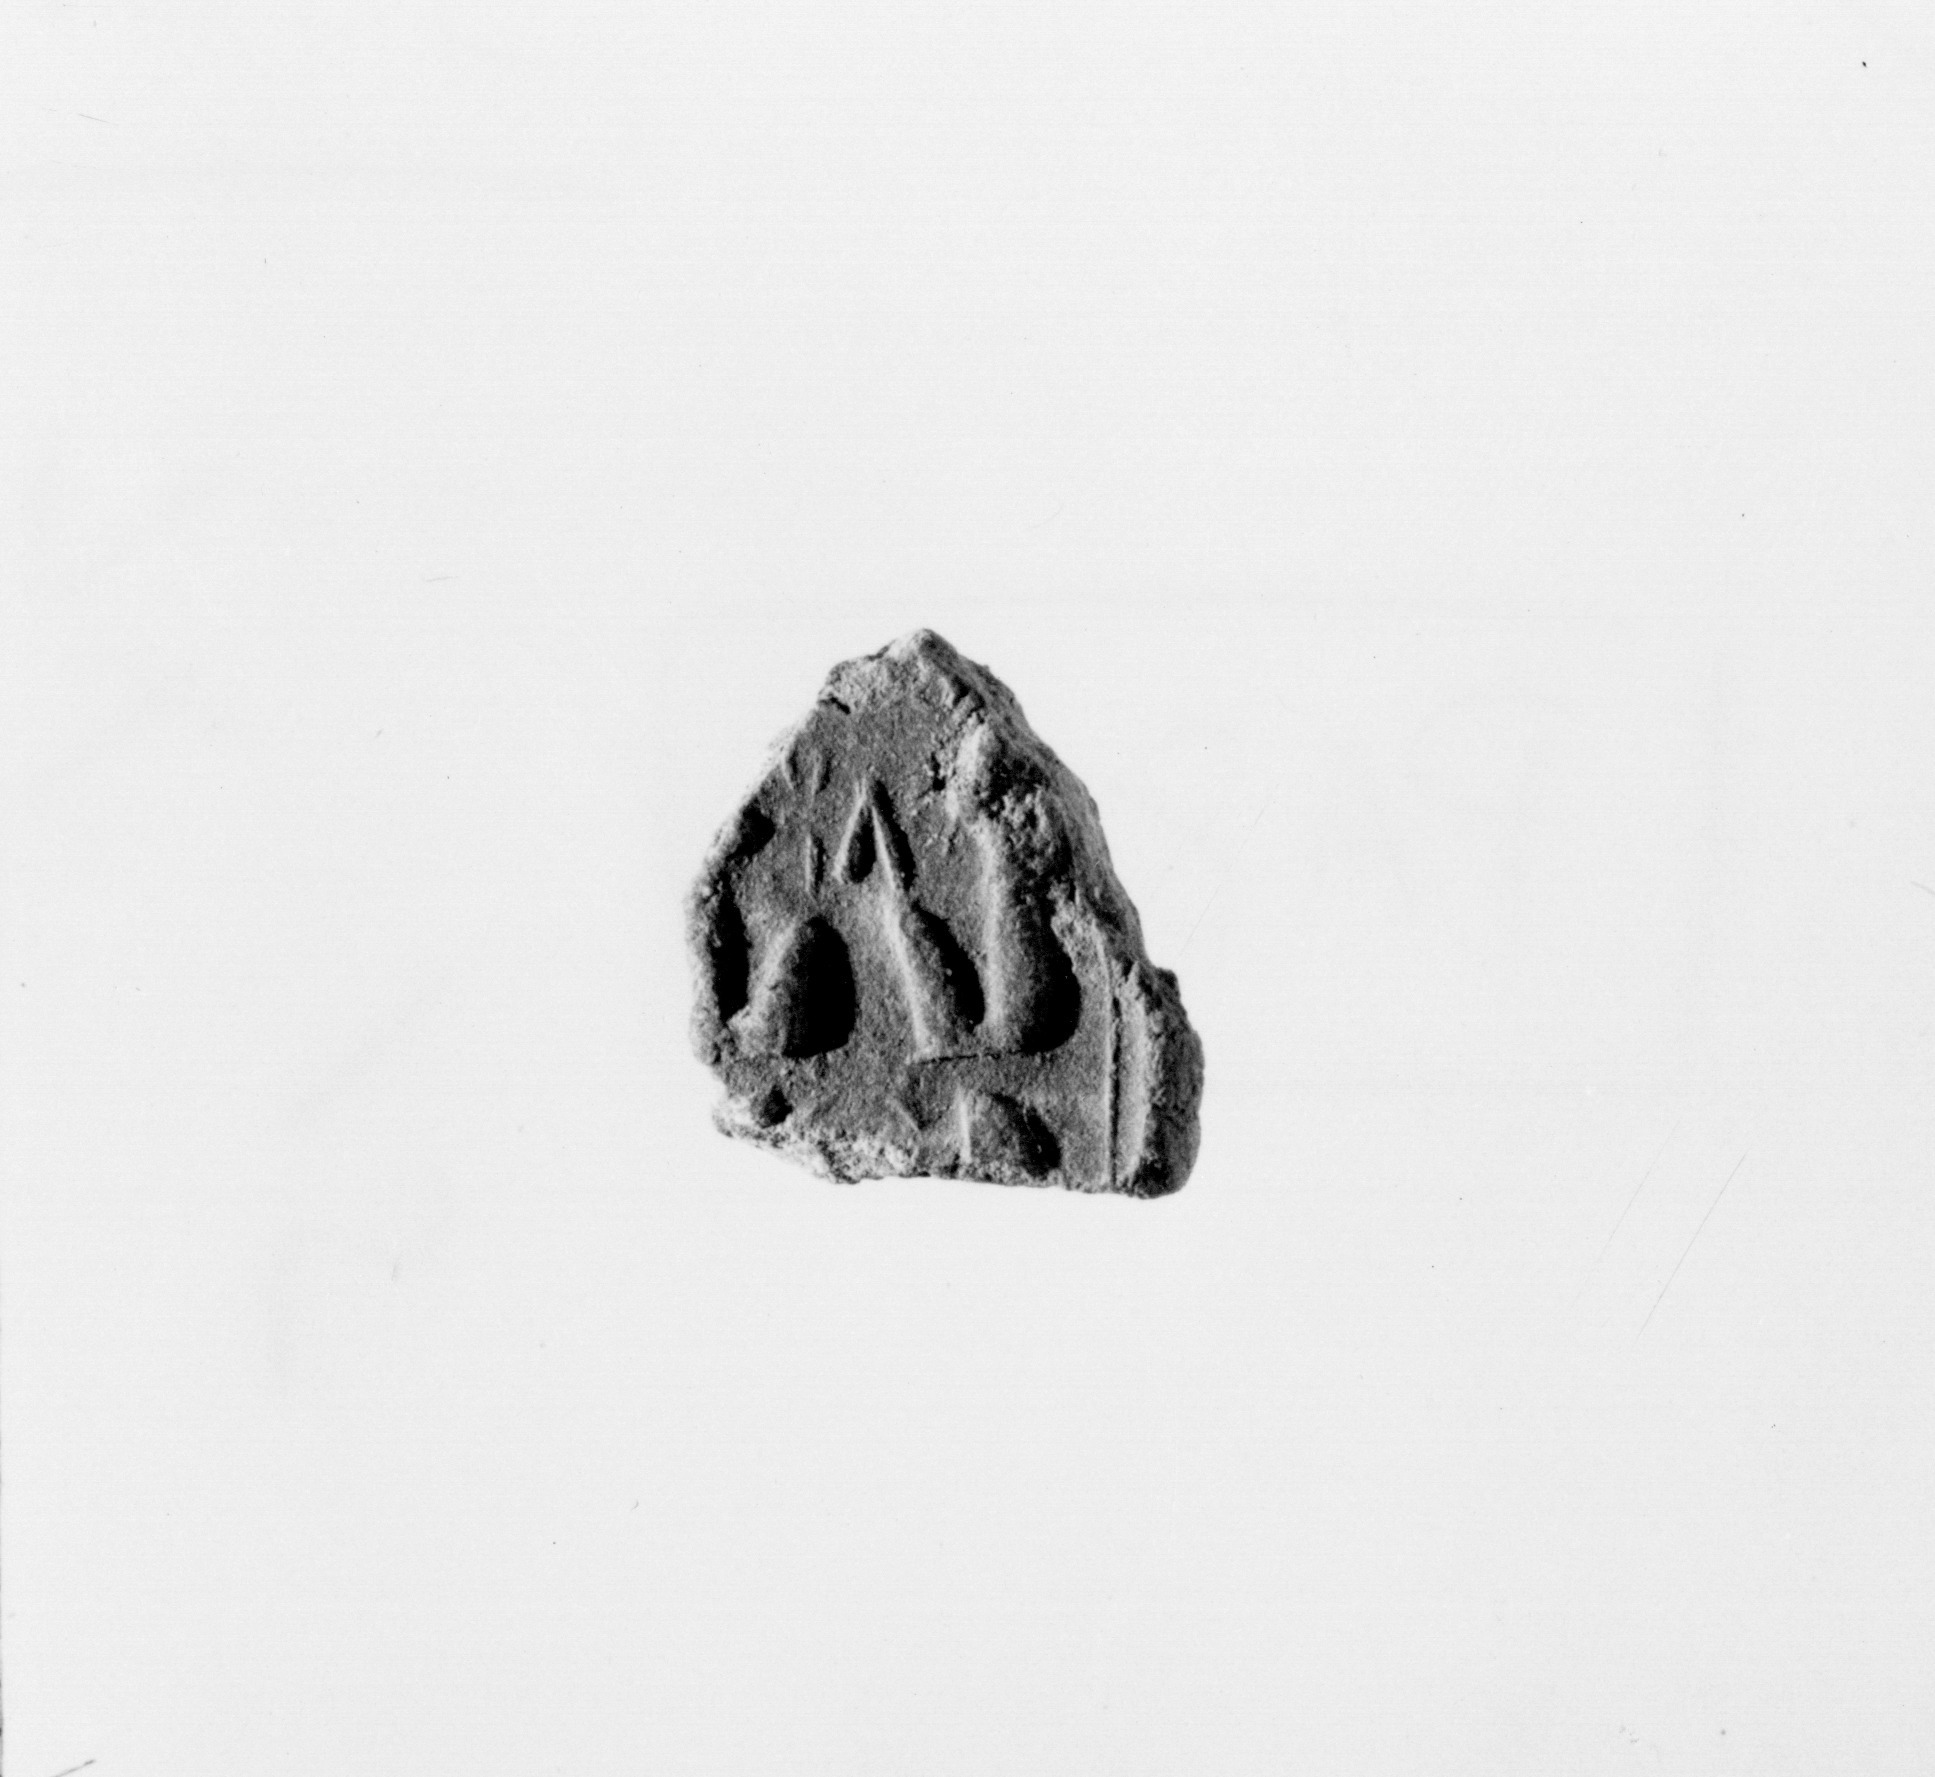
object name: sealing, nebmaatre, amenhotep iii,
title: Document Sealing With the Throne Name of Amenhotep III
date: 1390-1352 BCE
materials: mud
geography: egypt